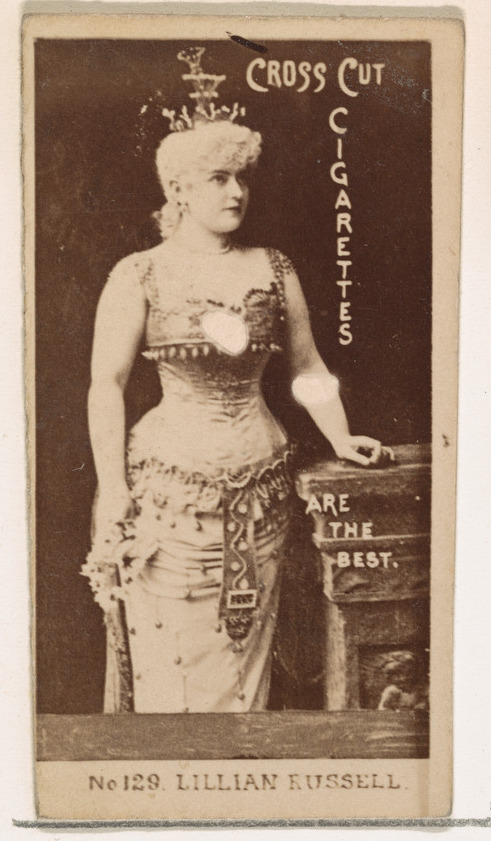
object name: print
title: Card Number 129, Lillian Russell, from the Actors and Actresses series (N145-2) issued by Duke Sons & Co. to promote Cross Cut Cigarettes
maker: w. duke, sons & co.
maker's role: publisher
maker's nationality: american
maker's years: 1870-1920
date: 1880-1889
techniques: albumen silver print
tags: portraits,women,actresses